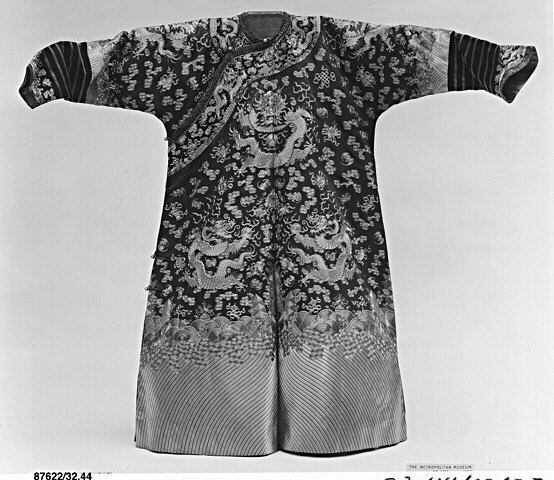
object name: robe, imperial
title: Imperial Court Robe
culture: chinese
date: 1801-1833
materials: metal thread, silk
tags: dragons